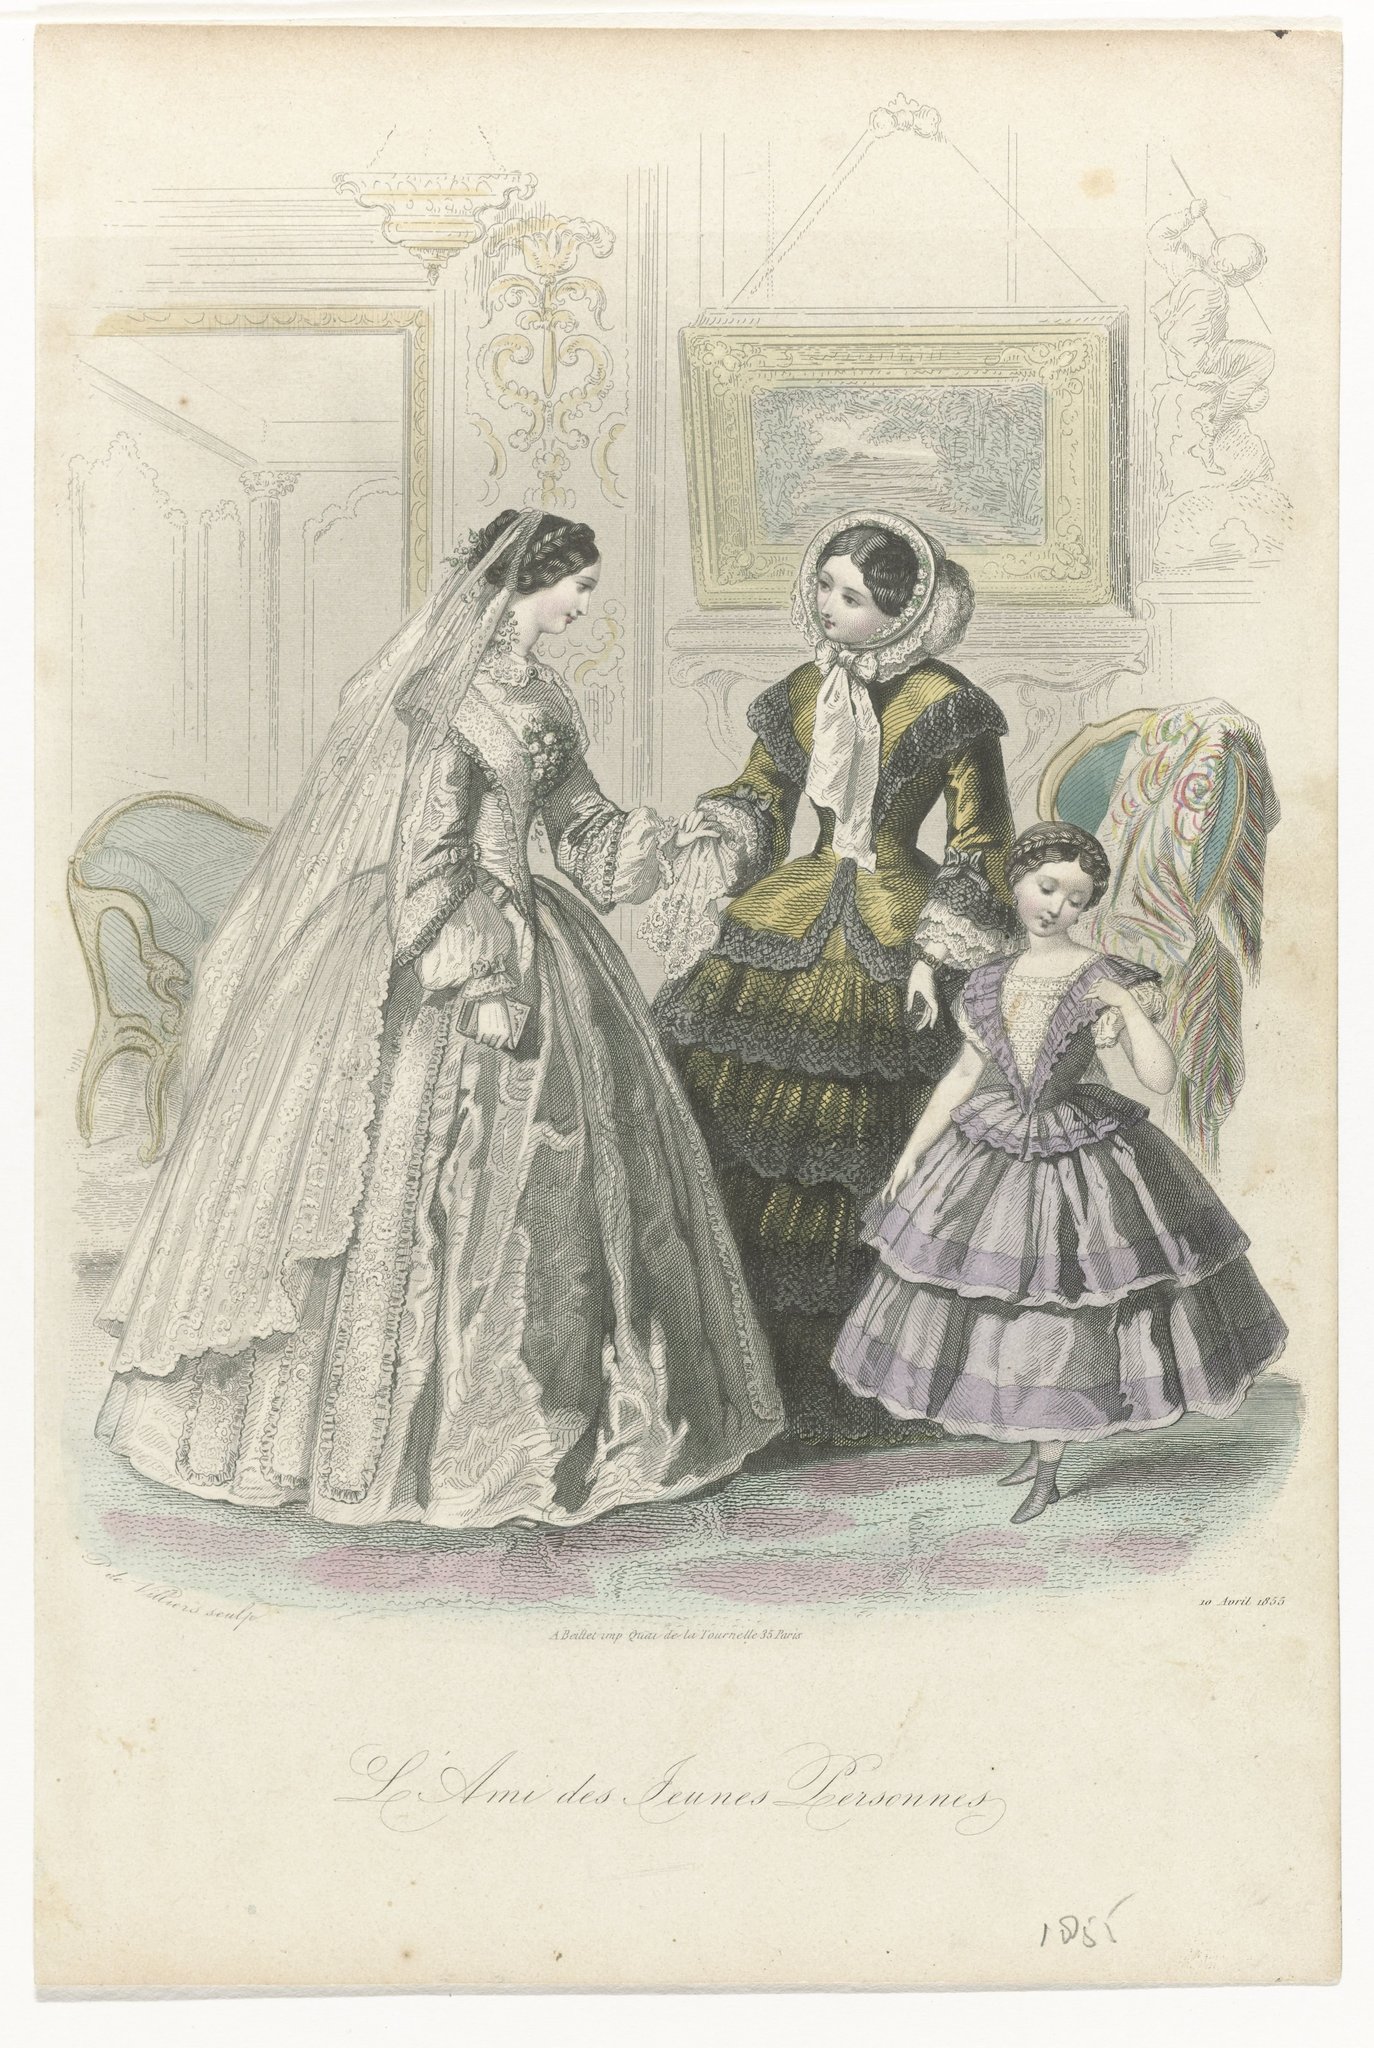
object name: fashion print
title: L'Ami des Jeunes Personnes, 10 Avril 1855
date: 1855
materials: paper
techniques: engraving, hand coloring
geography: paris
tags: handkerchief (+ women's clothes), clothes, costume (+ girls' clothes), veil (+ women's clothes), head-gear (+ women's clothes), fashion plates, book, bride (in wedding-dress), bracelet, wristlet (+ women's clothes)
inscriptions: title: ‘L'Ami des Jeunes Personnes’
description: Twee vrouwen en een meisje in een interieur. Links: hooggesloten bruidsjapon met puntig lijfje. Wijd uitlopende driekwart mouwen en poffende ondermouwen. Accessoires: lange doorzichtige sluier, bloemcorsage, handschoenen, zakdoek. Midden: mosgroene japon gegarneerd met gerimpelde stroken zwart kant. Wijd uitlopende driekwart mouwen en gerimpelde ondermouwen. Op het hoofd een hoed met striklinten. Rechts: lichtpaarse japon met korte mouwen en wijde strokenrok.